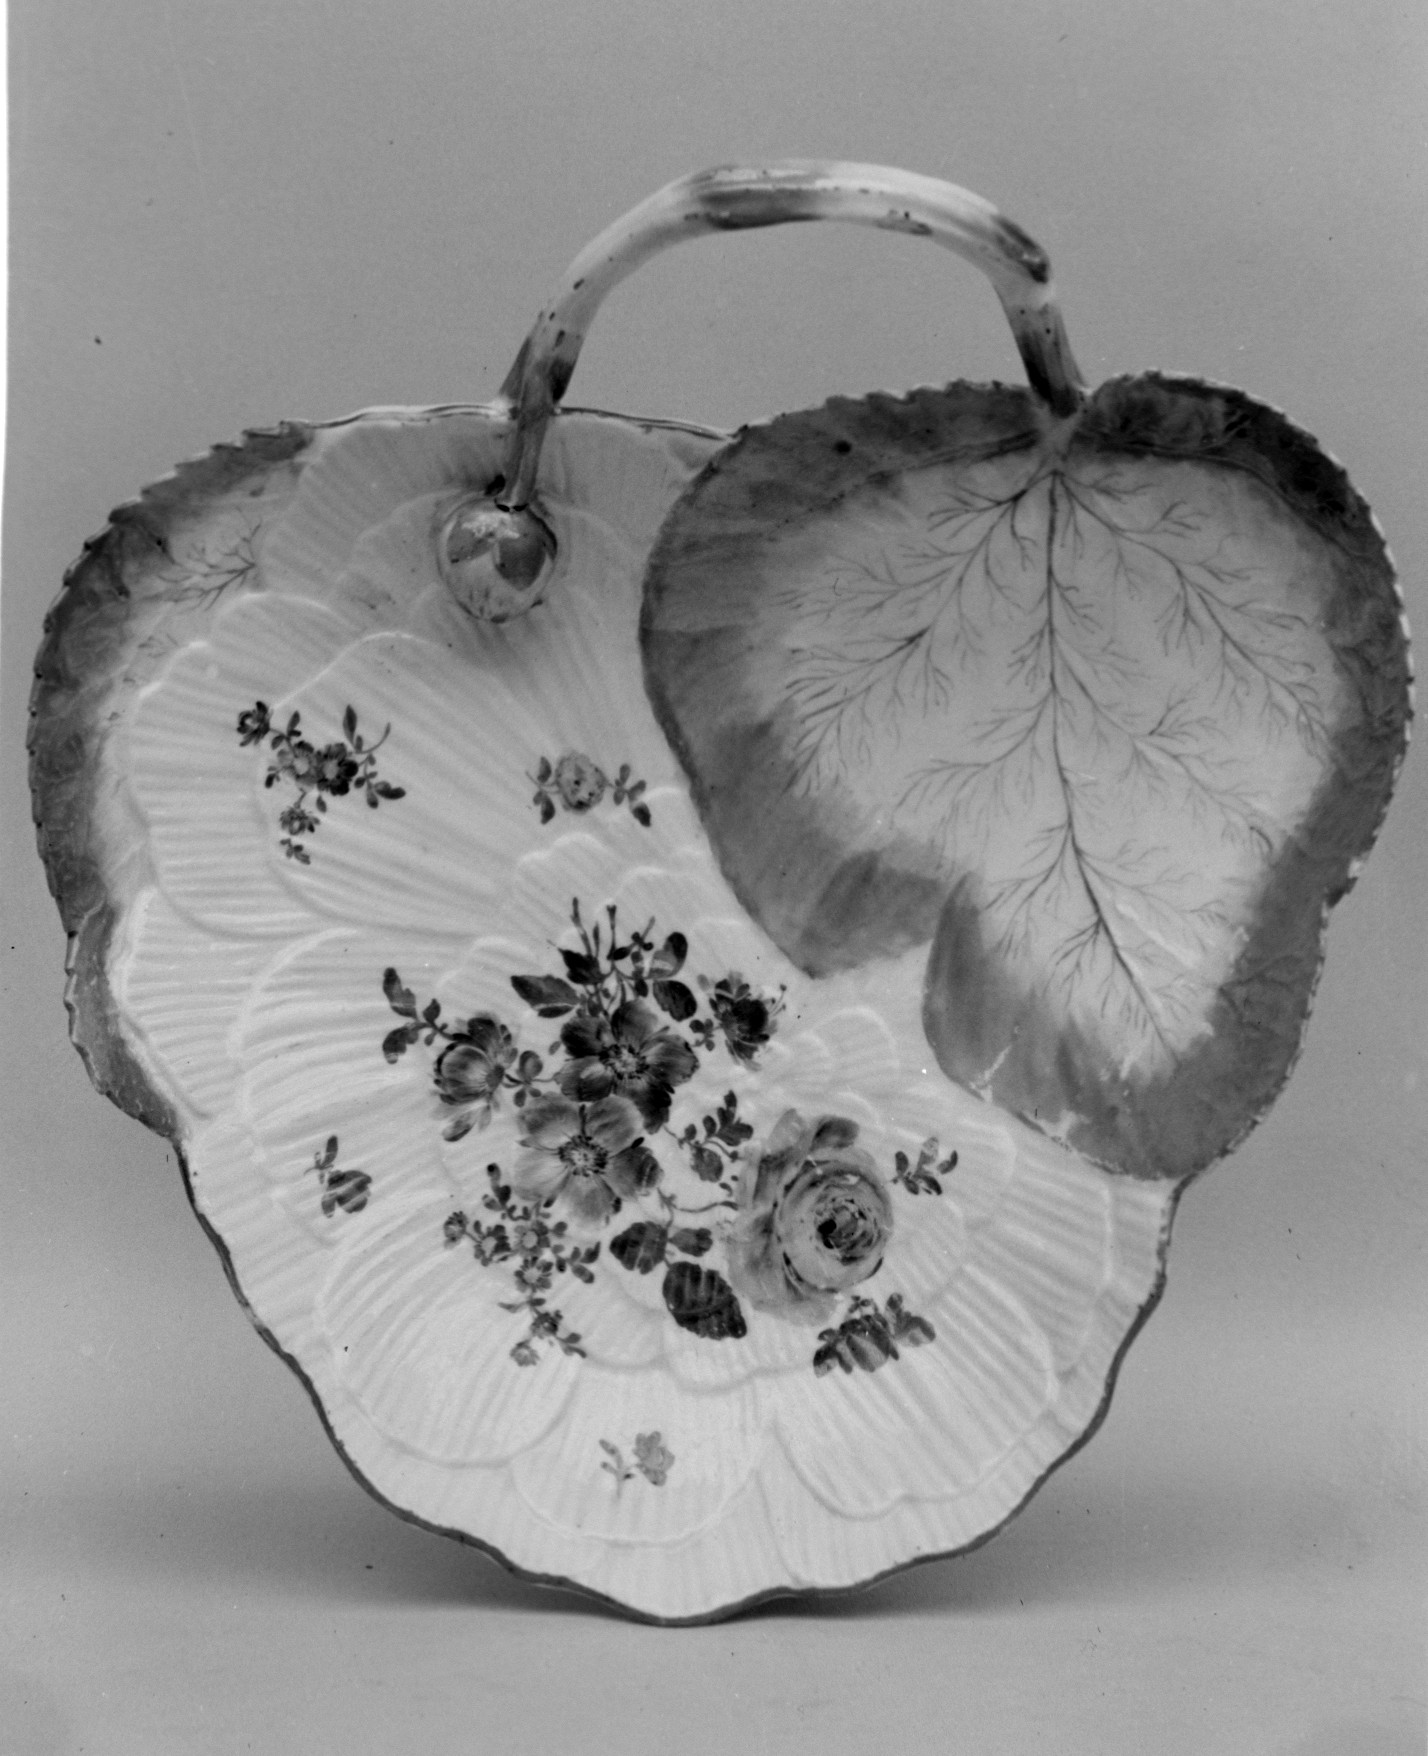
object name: dish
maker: meissen manufactory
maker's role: manufactory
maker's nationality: german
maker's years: 1710-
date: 1750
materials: hard paste porcelain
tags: flowers